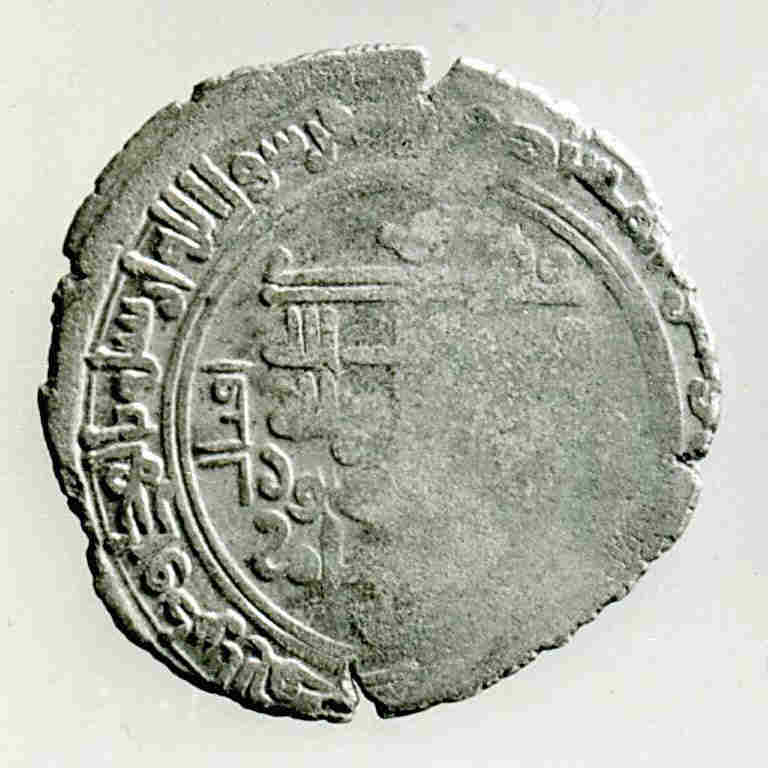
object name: coin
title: Dinar minted in Nishapur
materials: gold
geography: iran